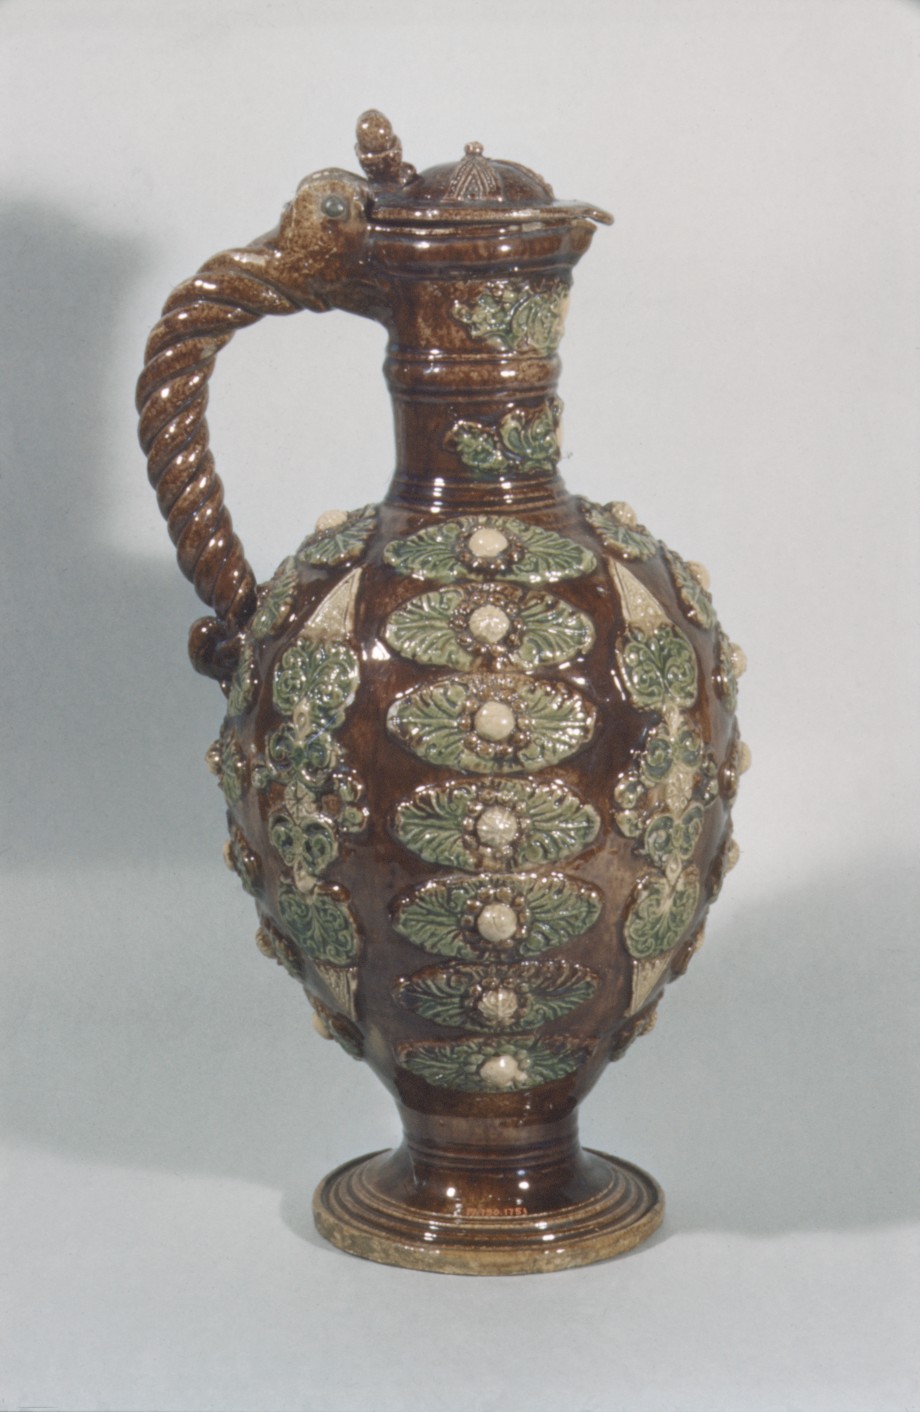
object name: jug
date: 1601-1700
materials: faience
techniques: glazing